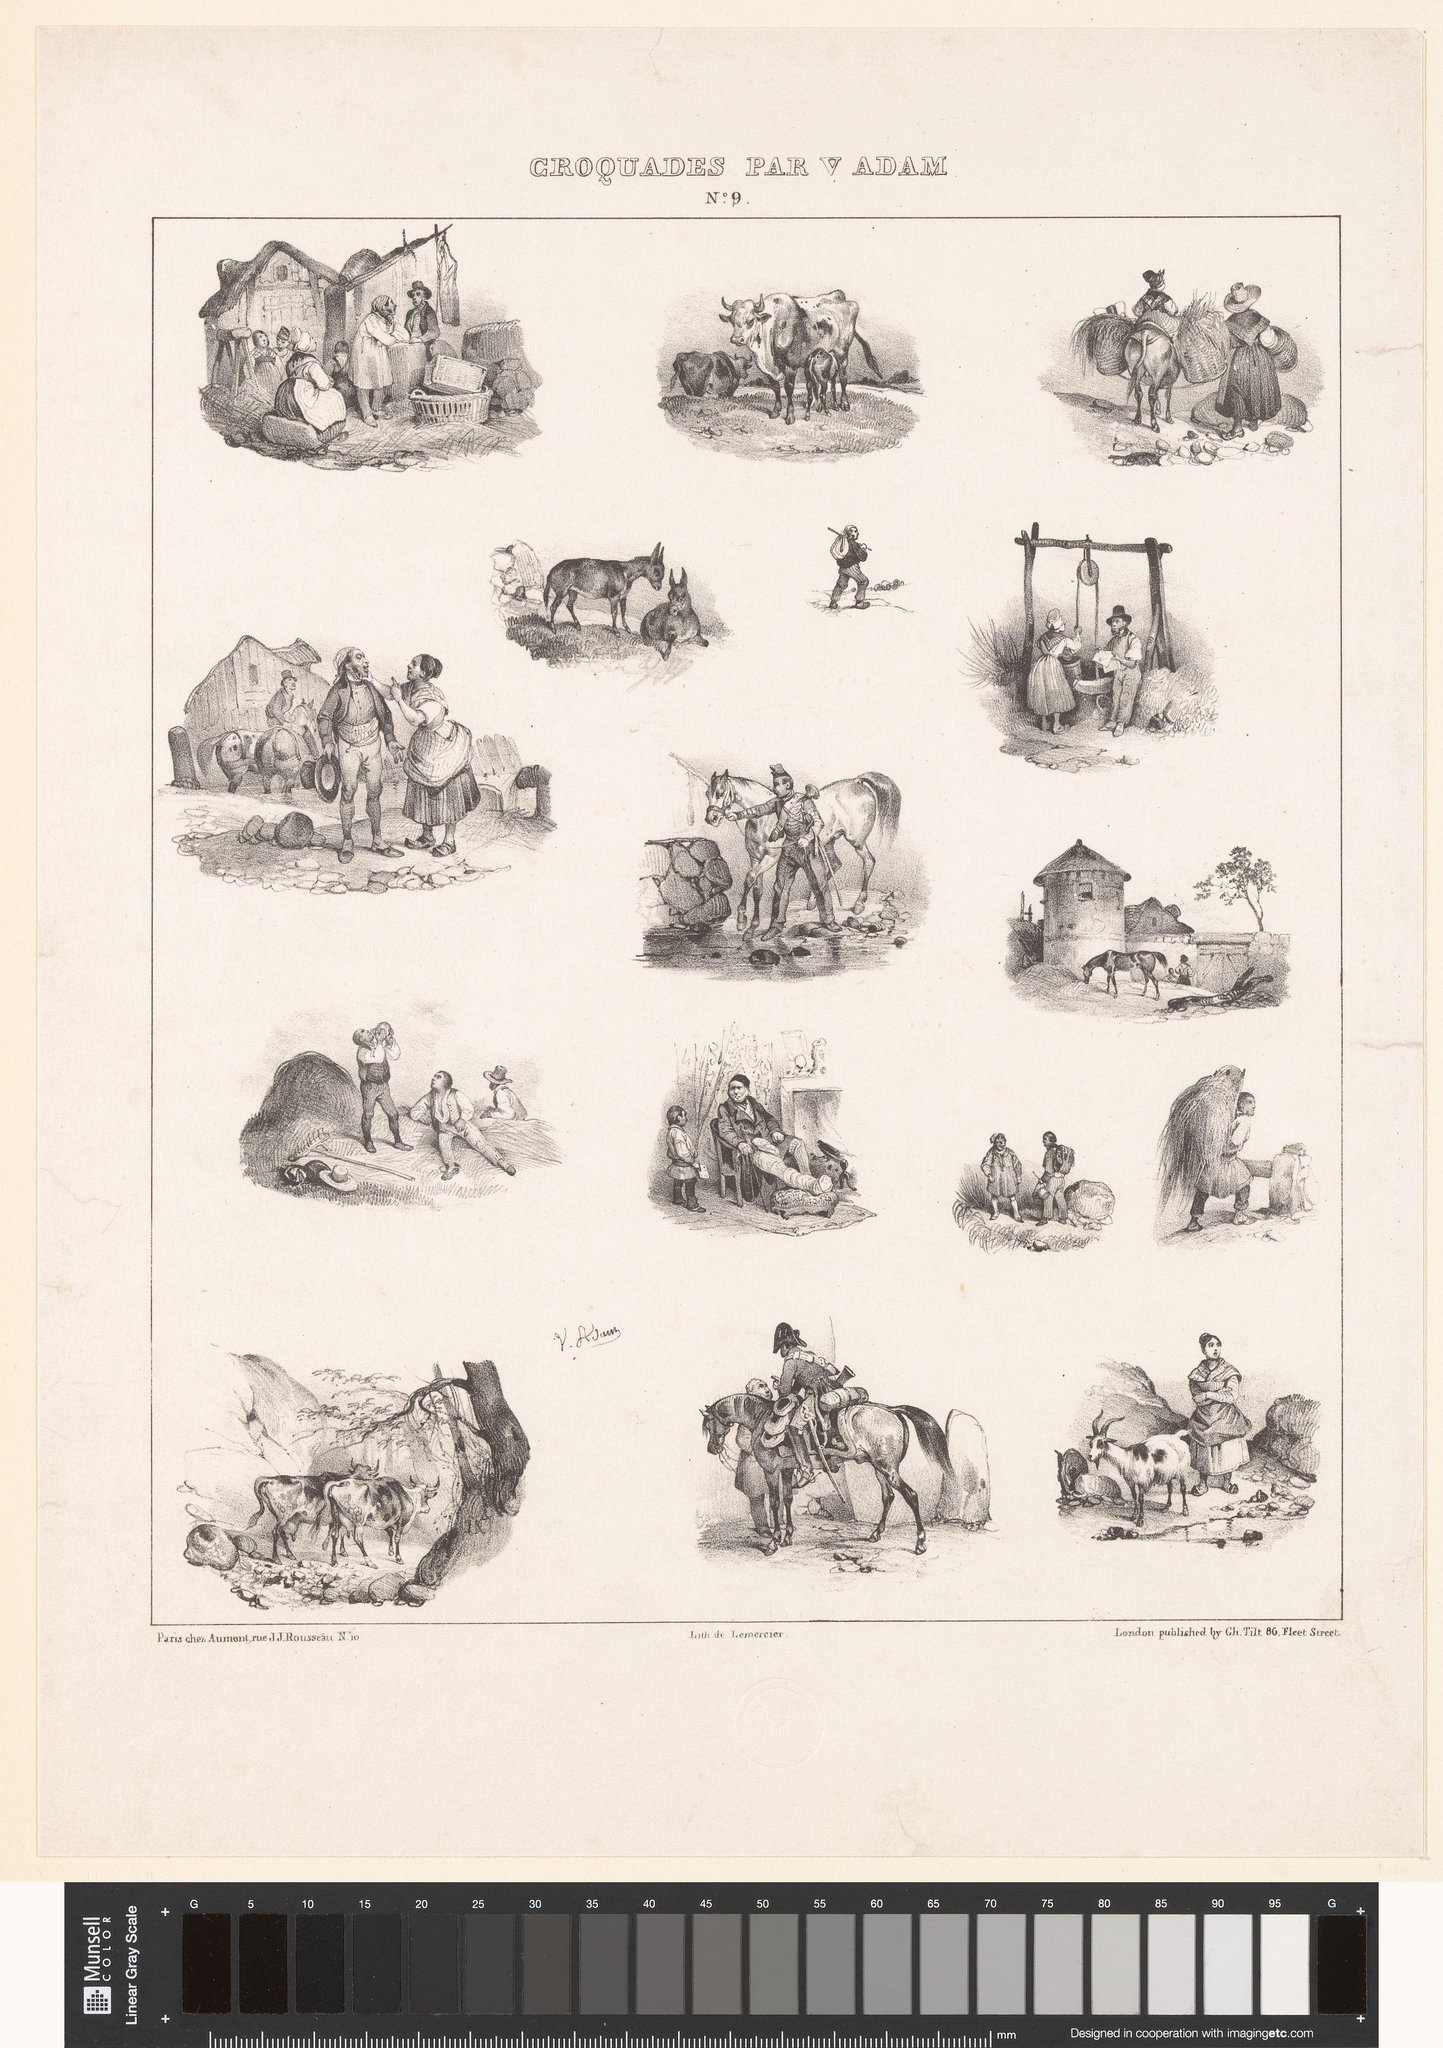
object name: print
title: Zestien voorstellingen uit het dagelijks leven met diverse menselijke figuren en dieren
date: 1832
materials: paper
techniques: lithograph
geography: paris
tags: riding a horse, ass, or mule; rider, horseman, well, cow, farmers, market, leading a horse by the reins; rider beside his horse, goat, mule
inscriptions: check stamp: Lugt 88b